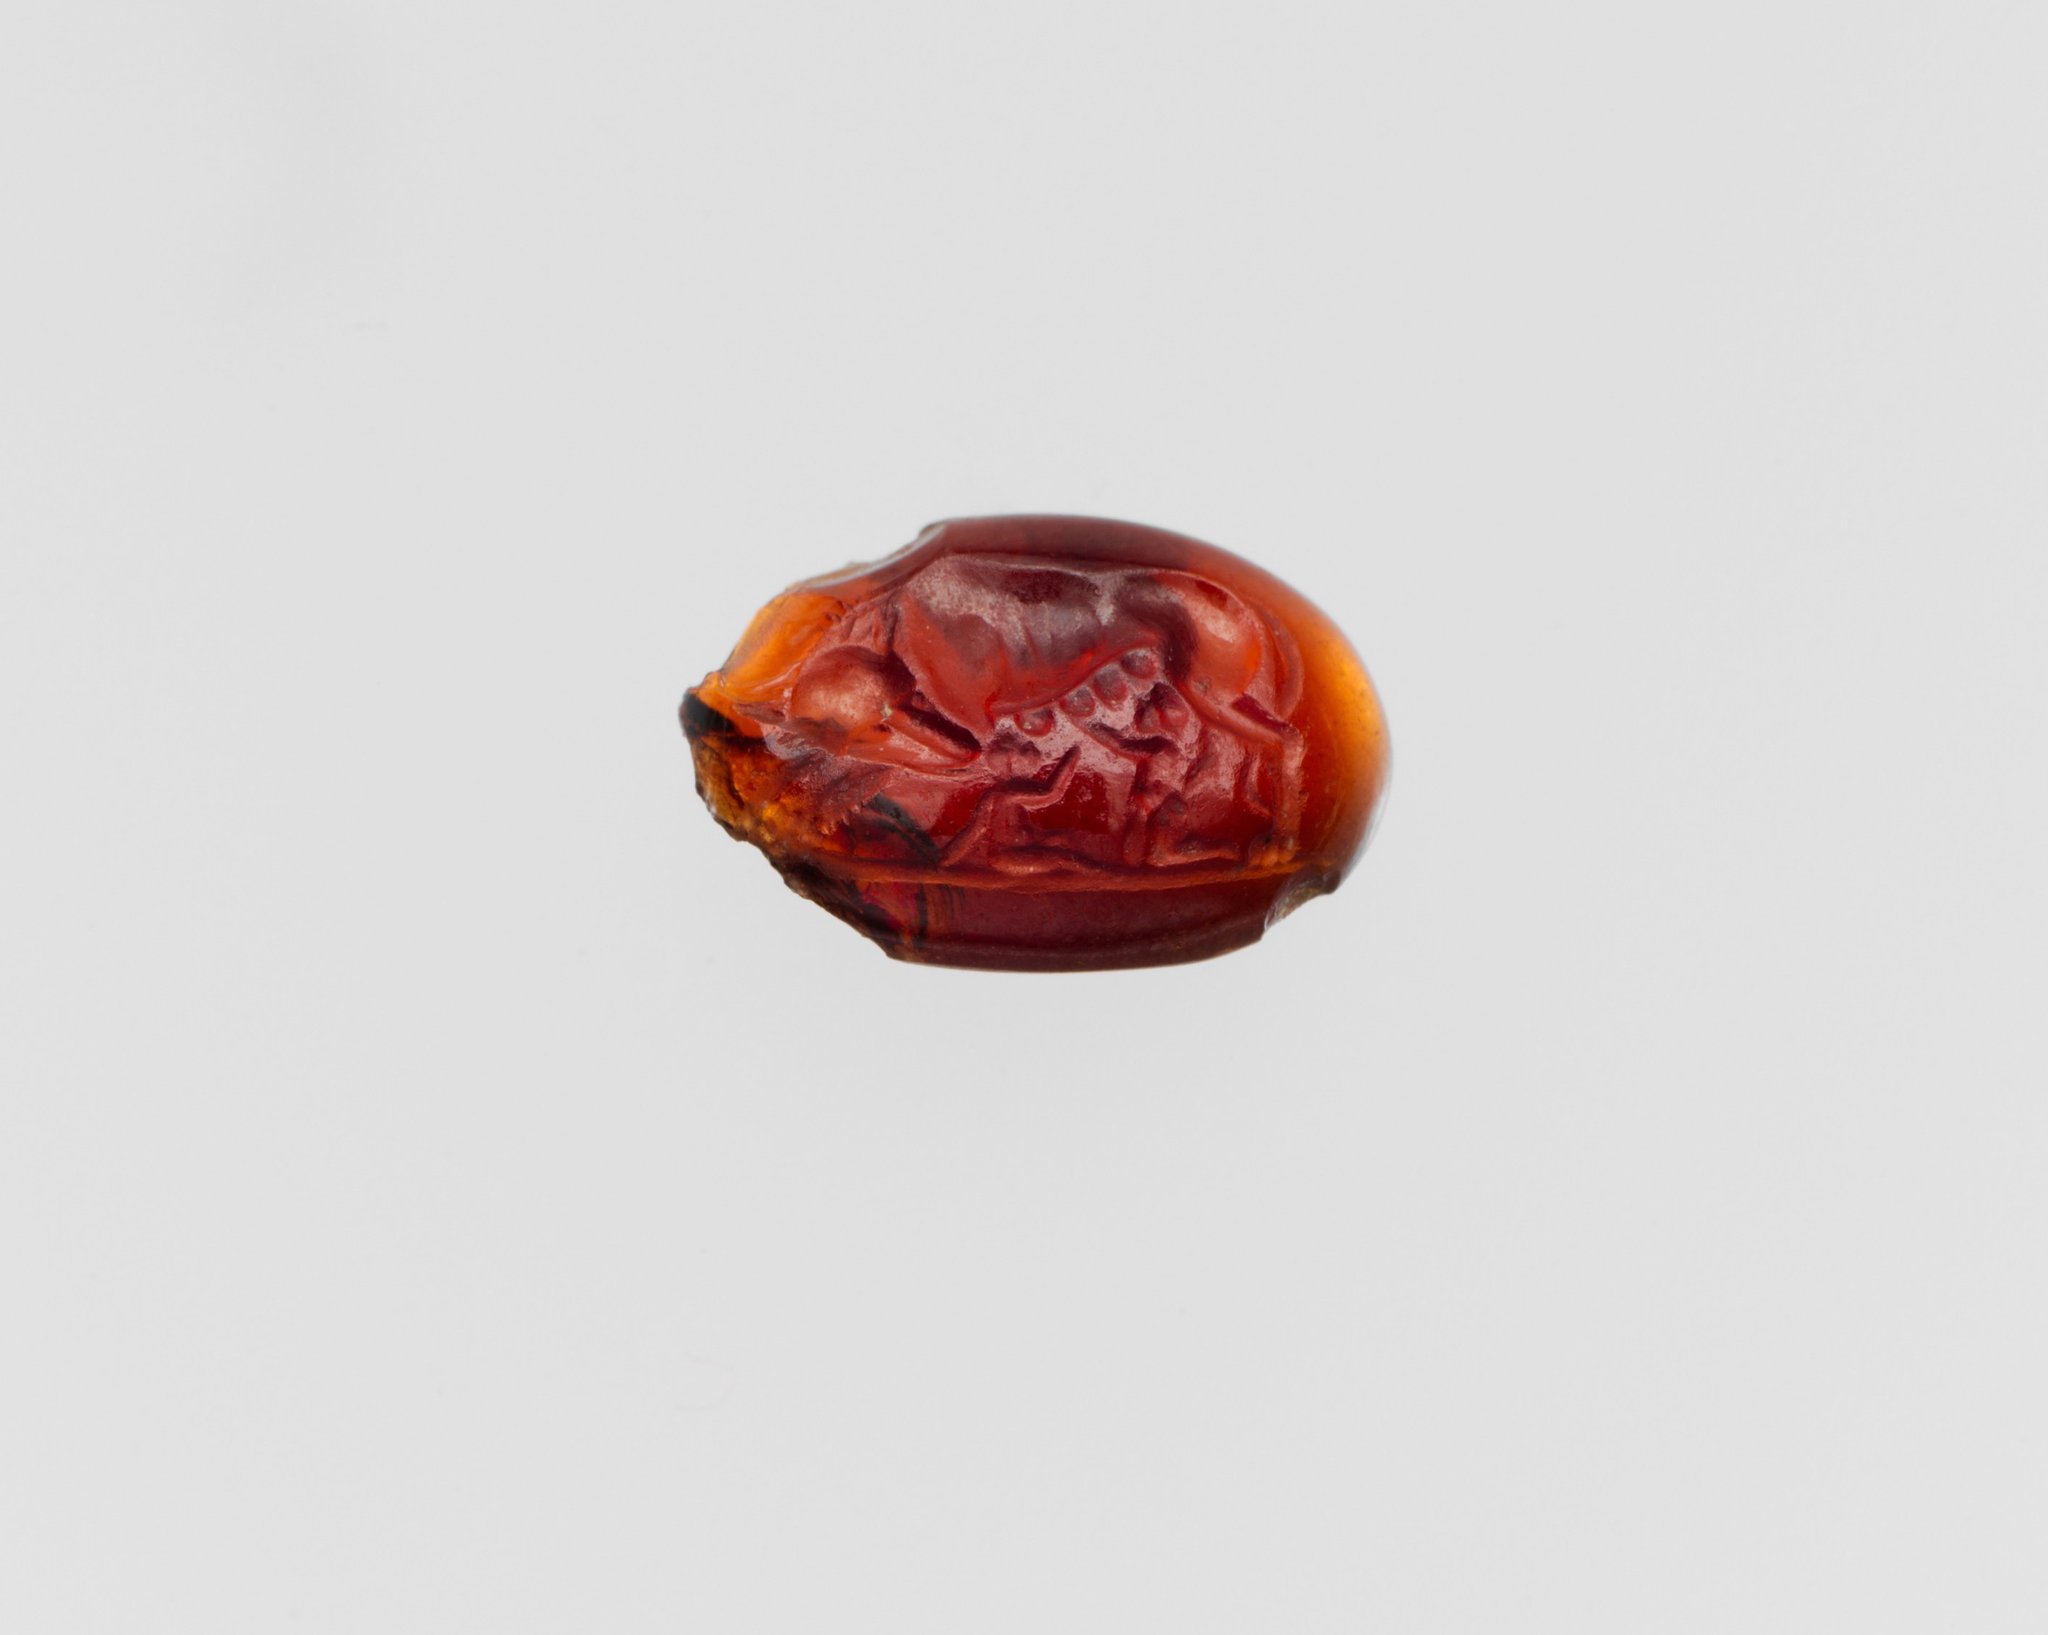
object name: intaglio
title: Garnet intaglio: Romulus, Remus, and the She-Wolf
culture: roman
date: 200 BCE-300 CE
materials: gemstone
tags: animals,infants